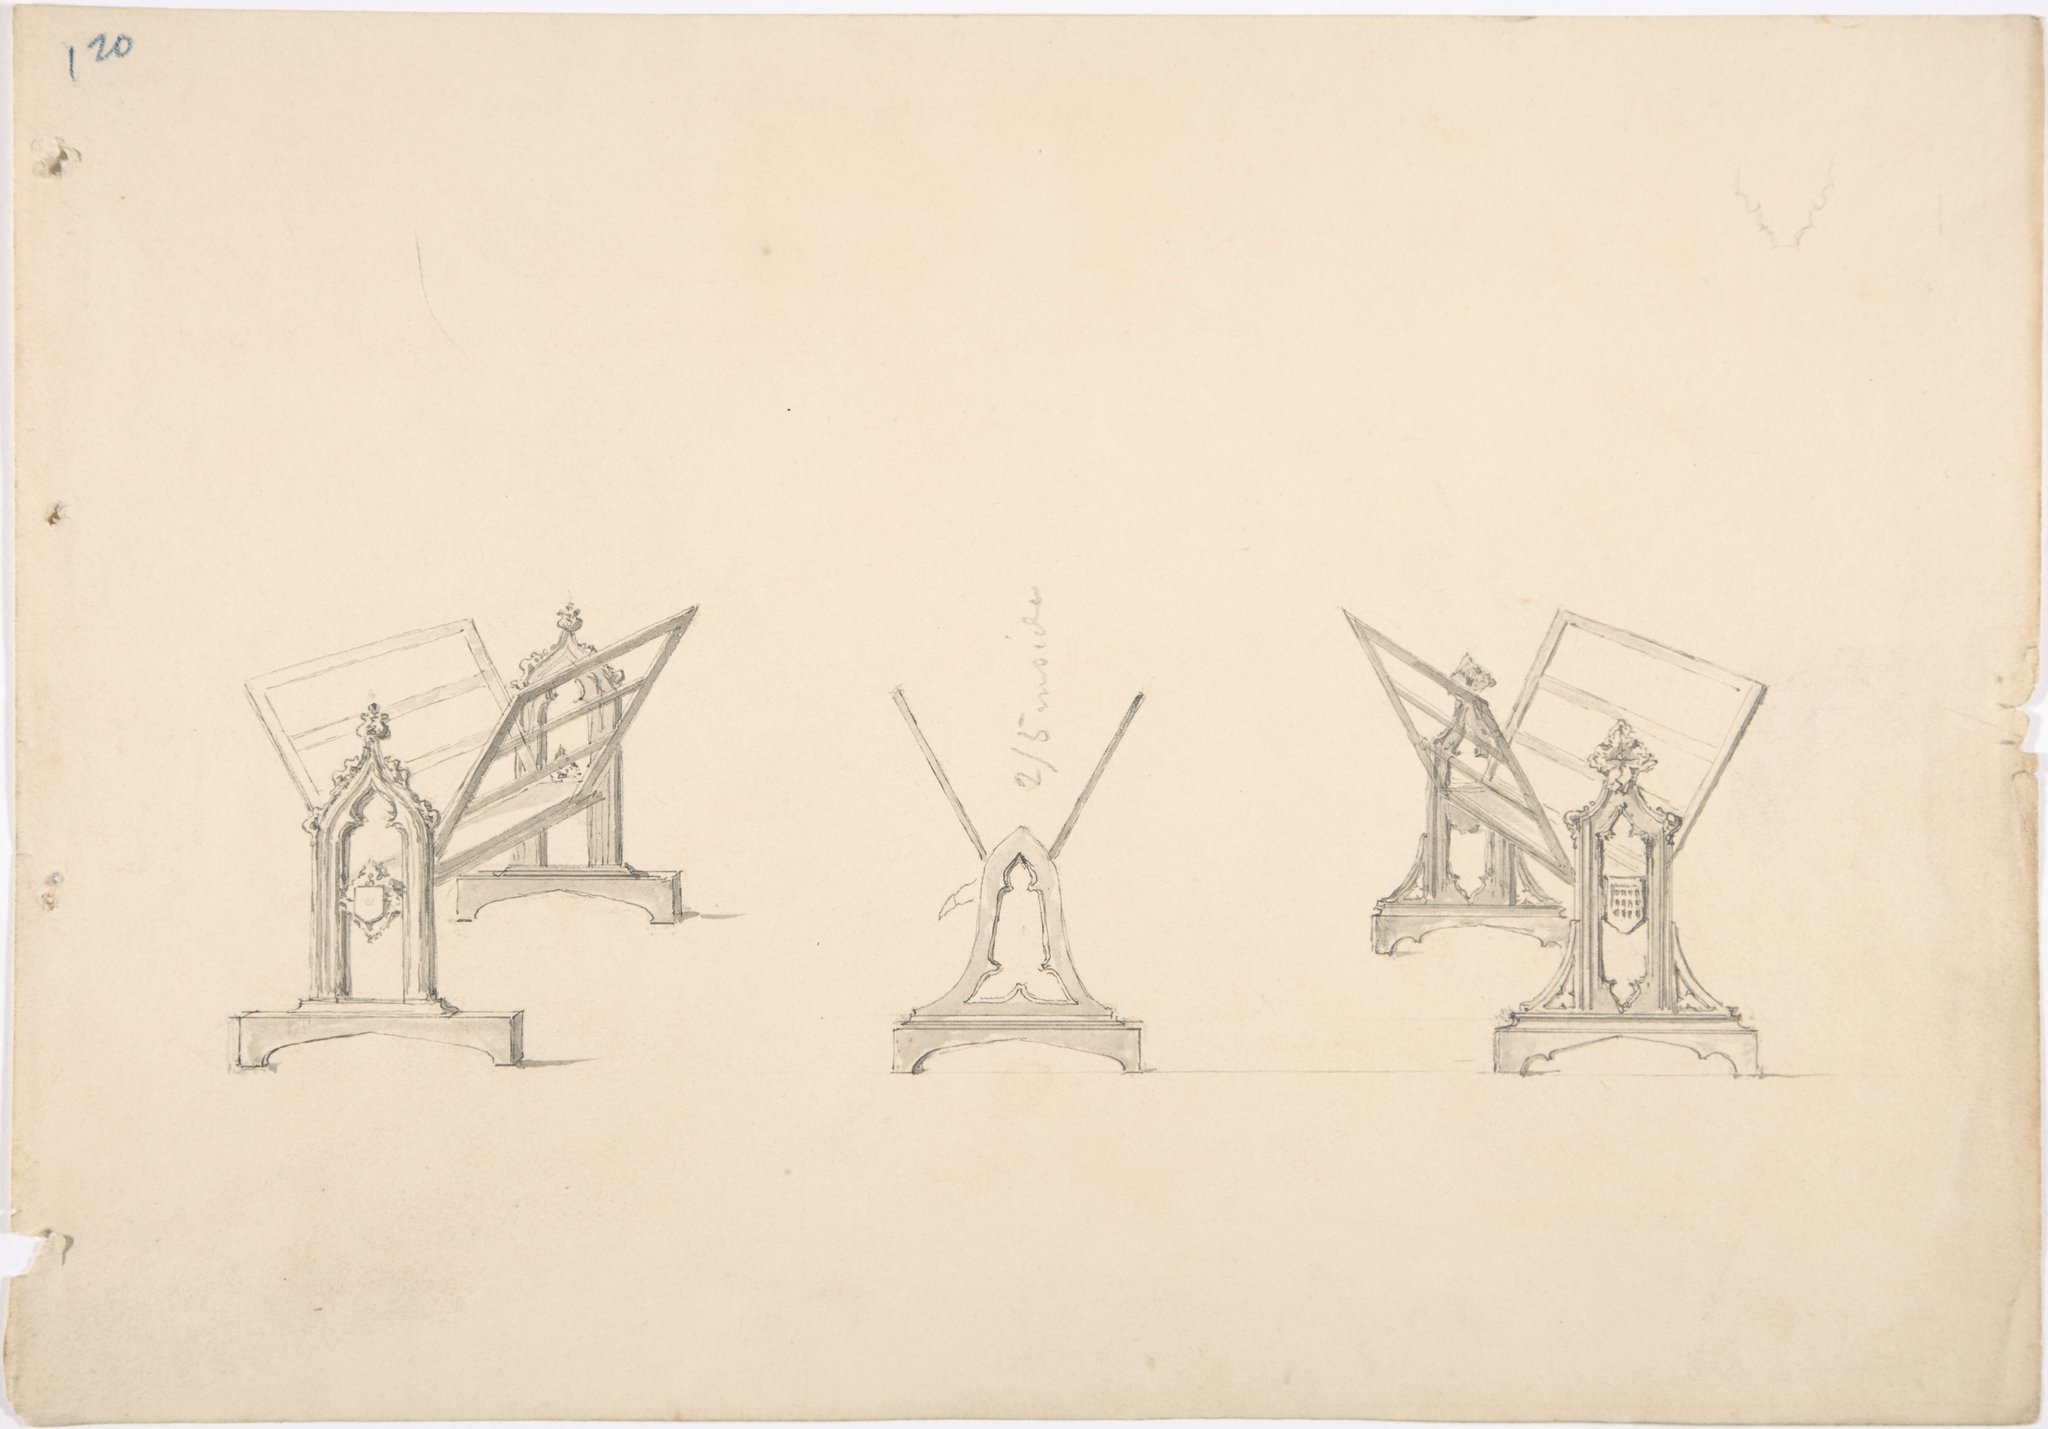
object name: drawing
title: Design for Three Gothic Style Book Stands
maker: anonymous, british, 19th century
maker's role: artist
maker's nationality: british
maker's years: 1800-1900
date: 1801-1833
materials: graphite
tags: furniture